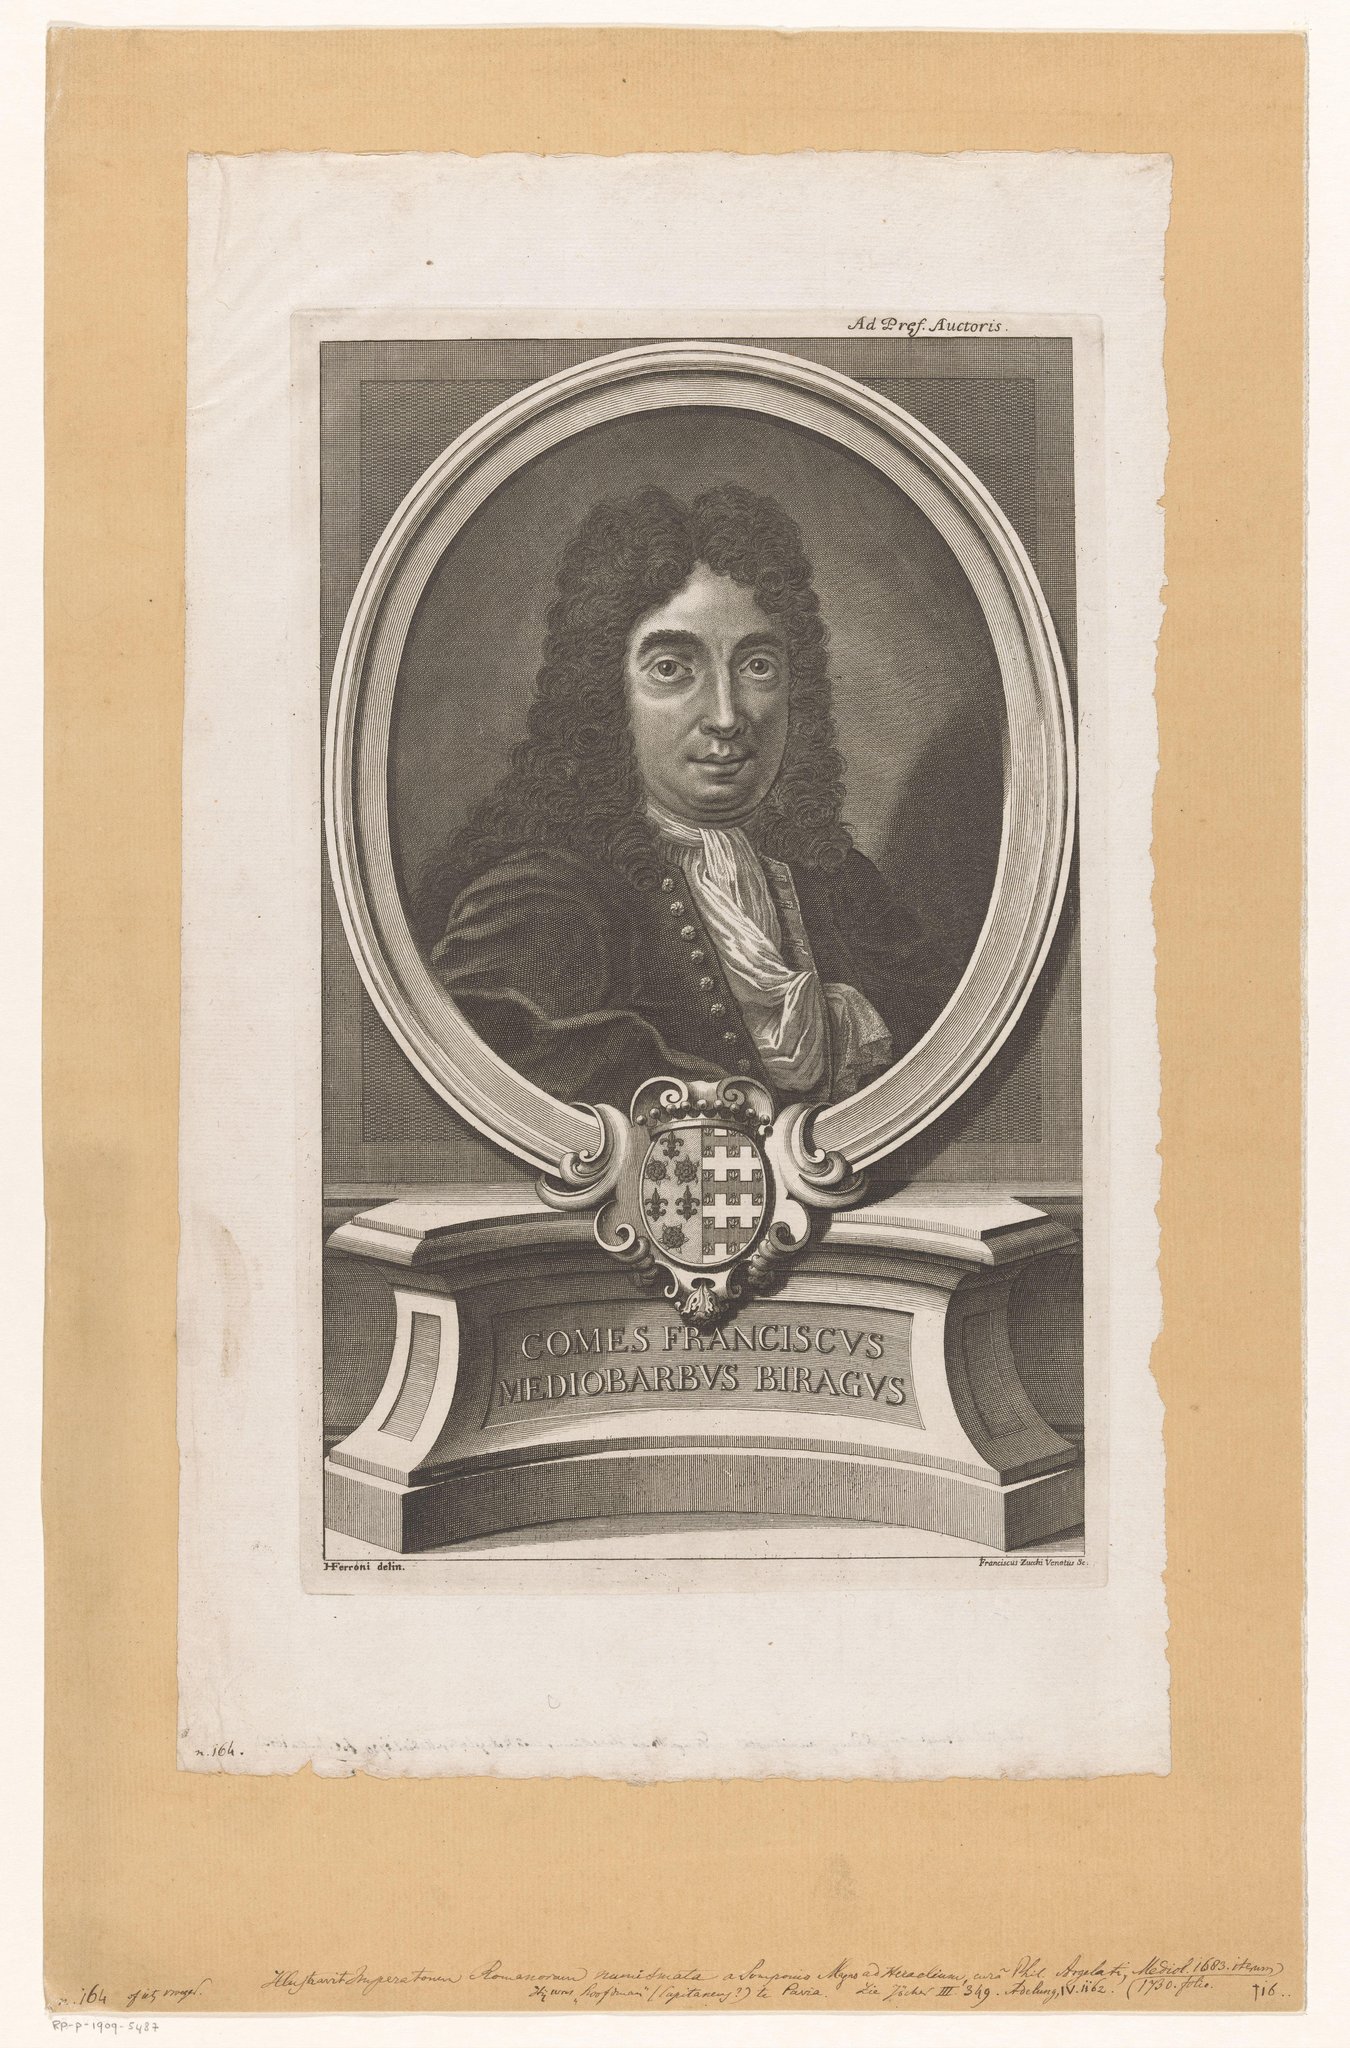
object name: print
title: Portret van graaf Francesco Mezzabarba Birago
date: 1702-1764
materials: paper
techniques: engraving, etching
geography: italy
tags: earl, historical persons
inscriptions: inscription: ‘illustravit imperatori Ra[...] numismata a Pomp. M. ad Heraclium, cura Ph. Angelati, Mediol. 1730. fol [...] 1683’, collector's mark: Lugt 2228, inscription: ‘n. 164.’